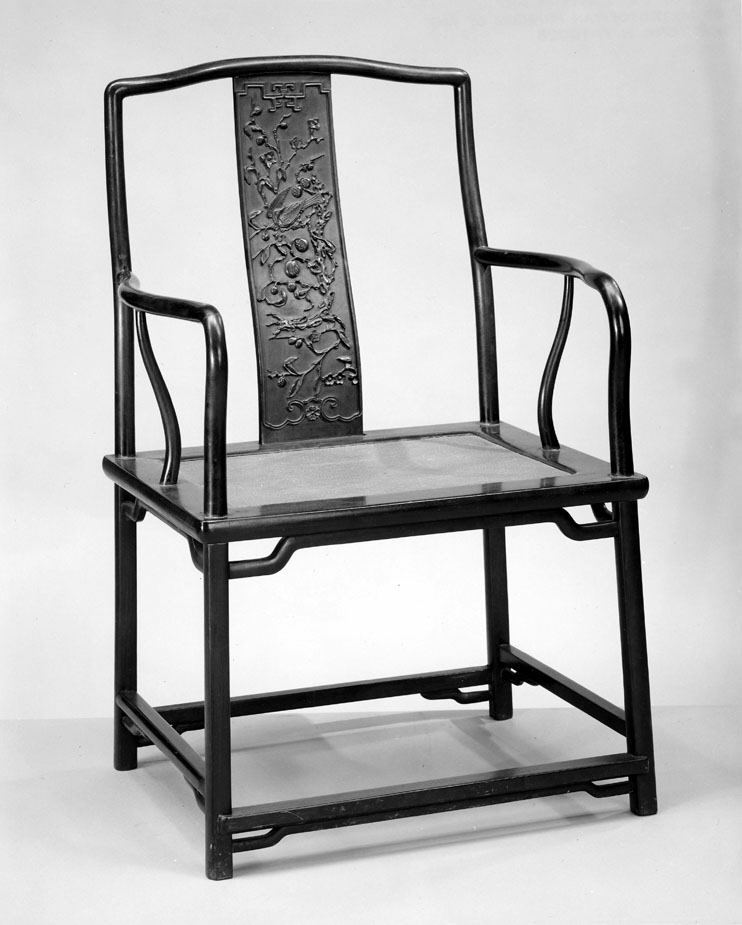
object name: armchair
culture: chinese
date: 1701-1900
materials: wood